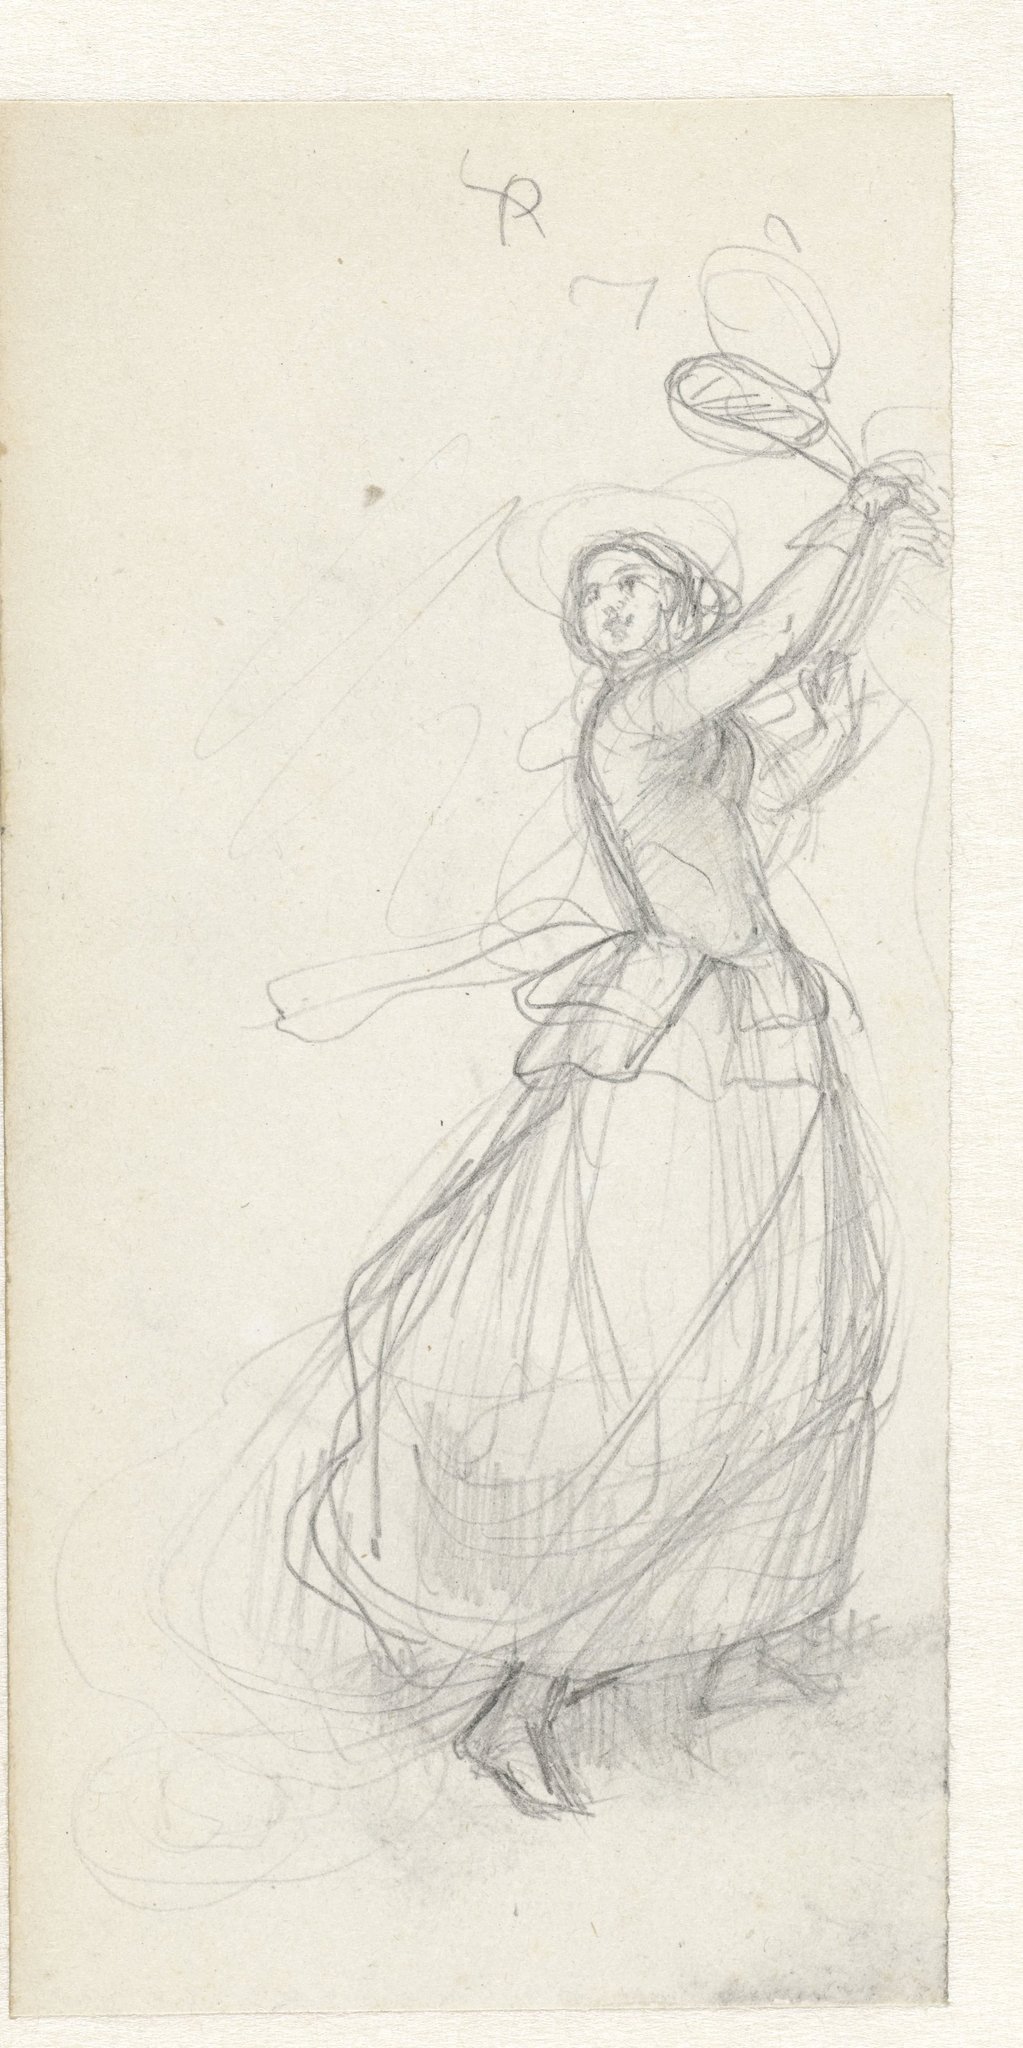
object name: drawing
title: Studie van een vrouw die tennis of badminton speelt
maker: august allebé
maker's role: draughtsman, print maker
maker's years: 1838-1927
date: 1848-1927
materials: paper, pencil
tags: tennis, lawn-tennis, 'jeu de volant', badminton